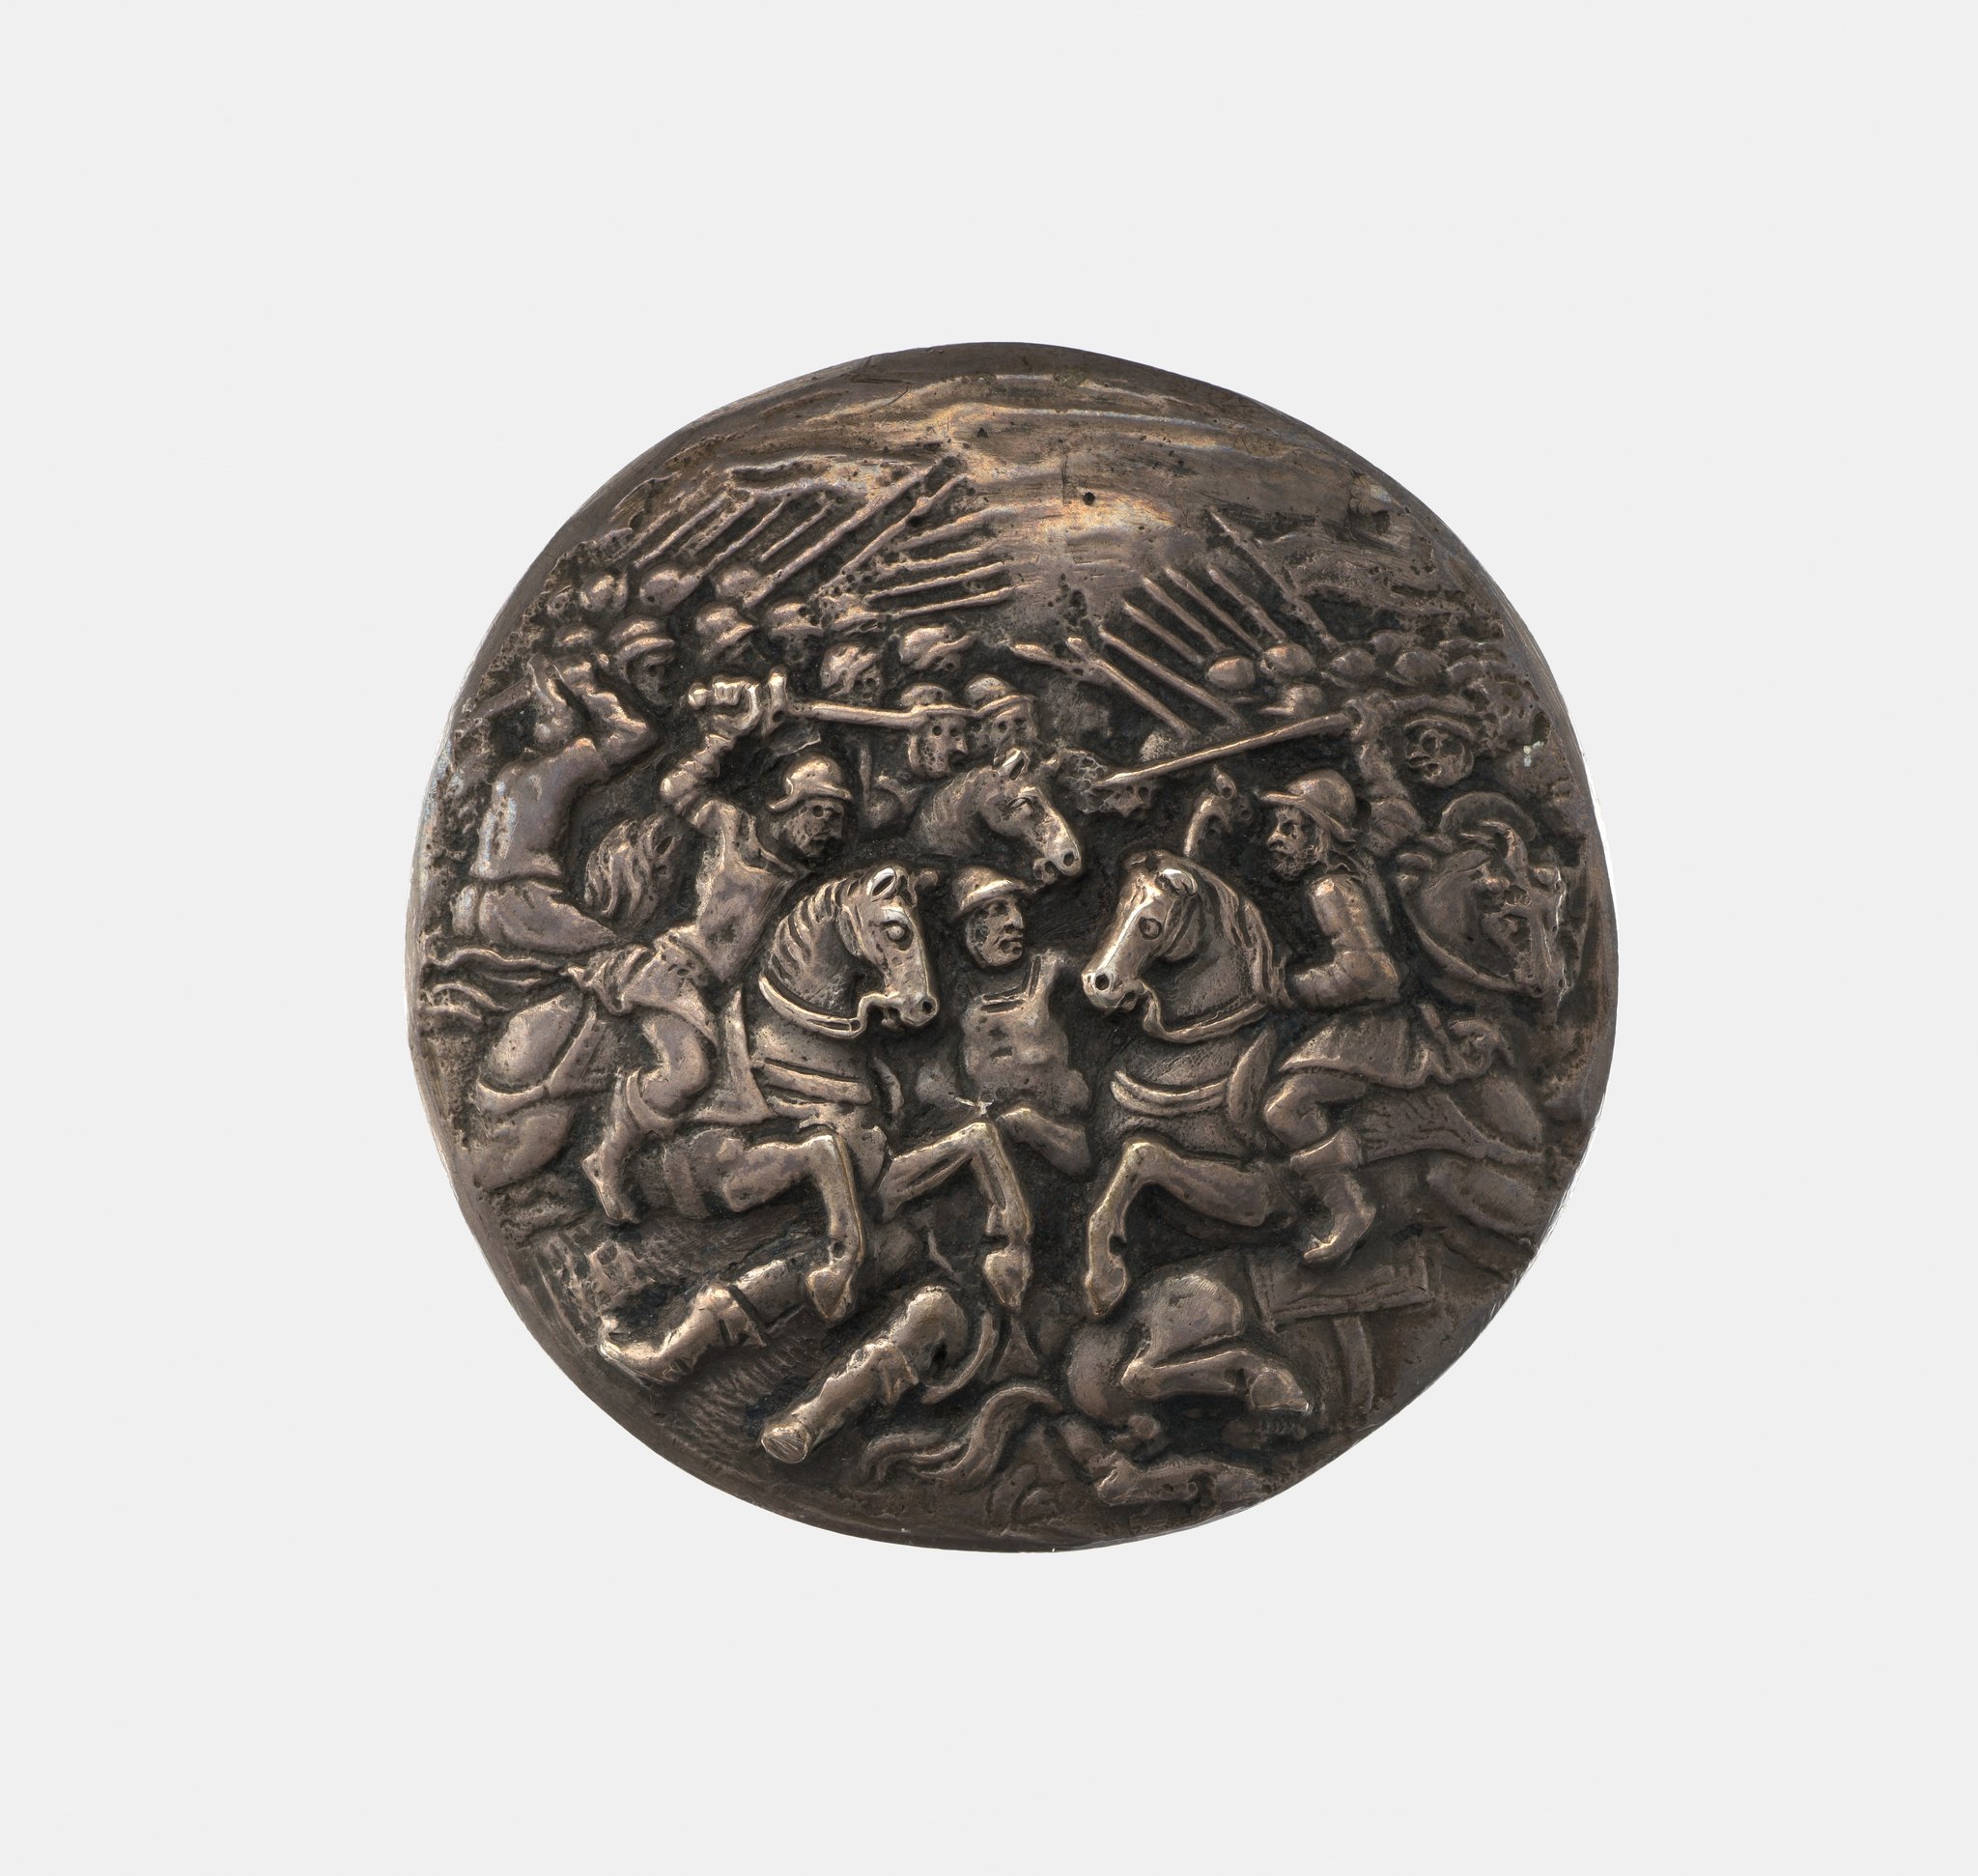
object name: badge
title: Roman Combat (Battle at Cannae?)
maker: Anonymous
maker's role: artist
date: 1494-1553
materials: silver